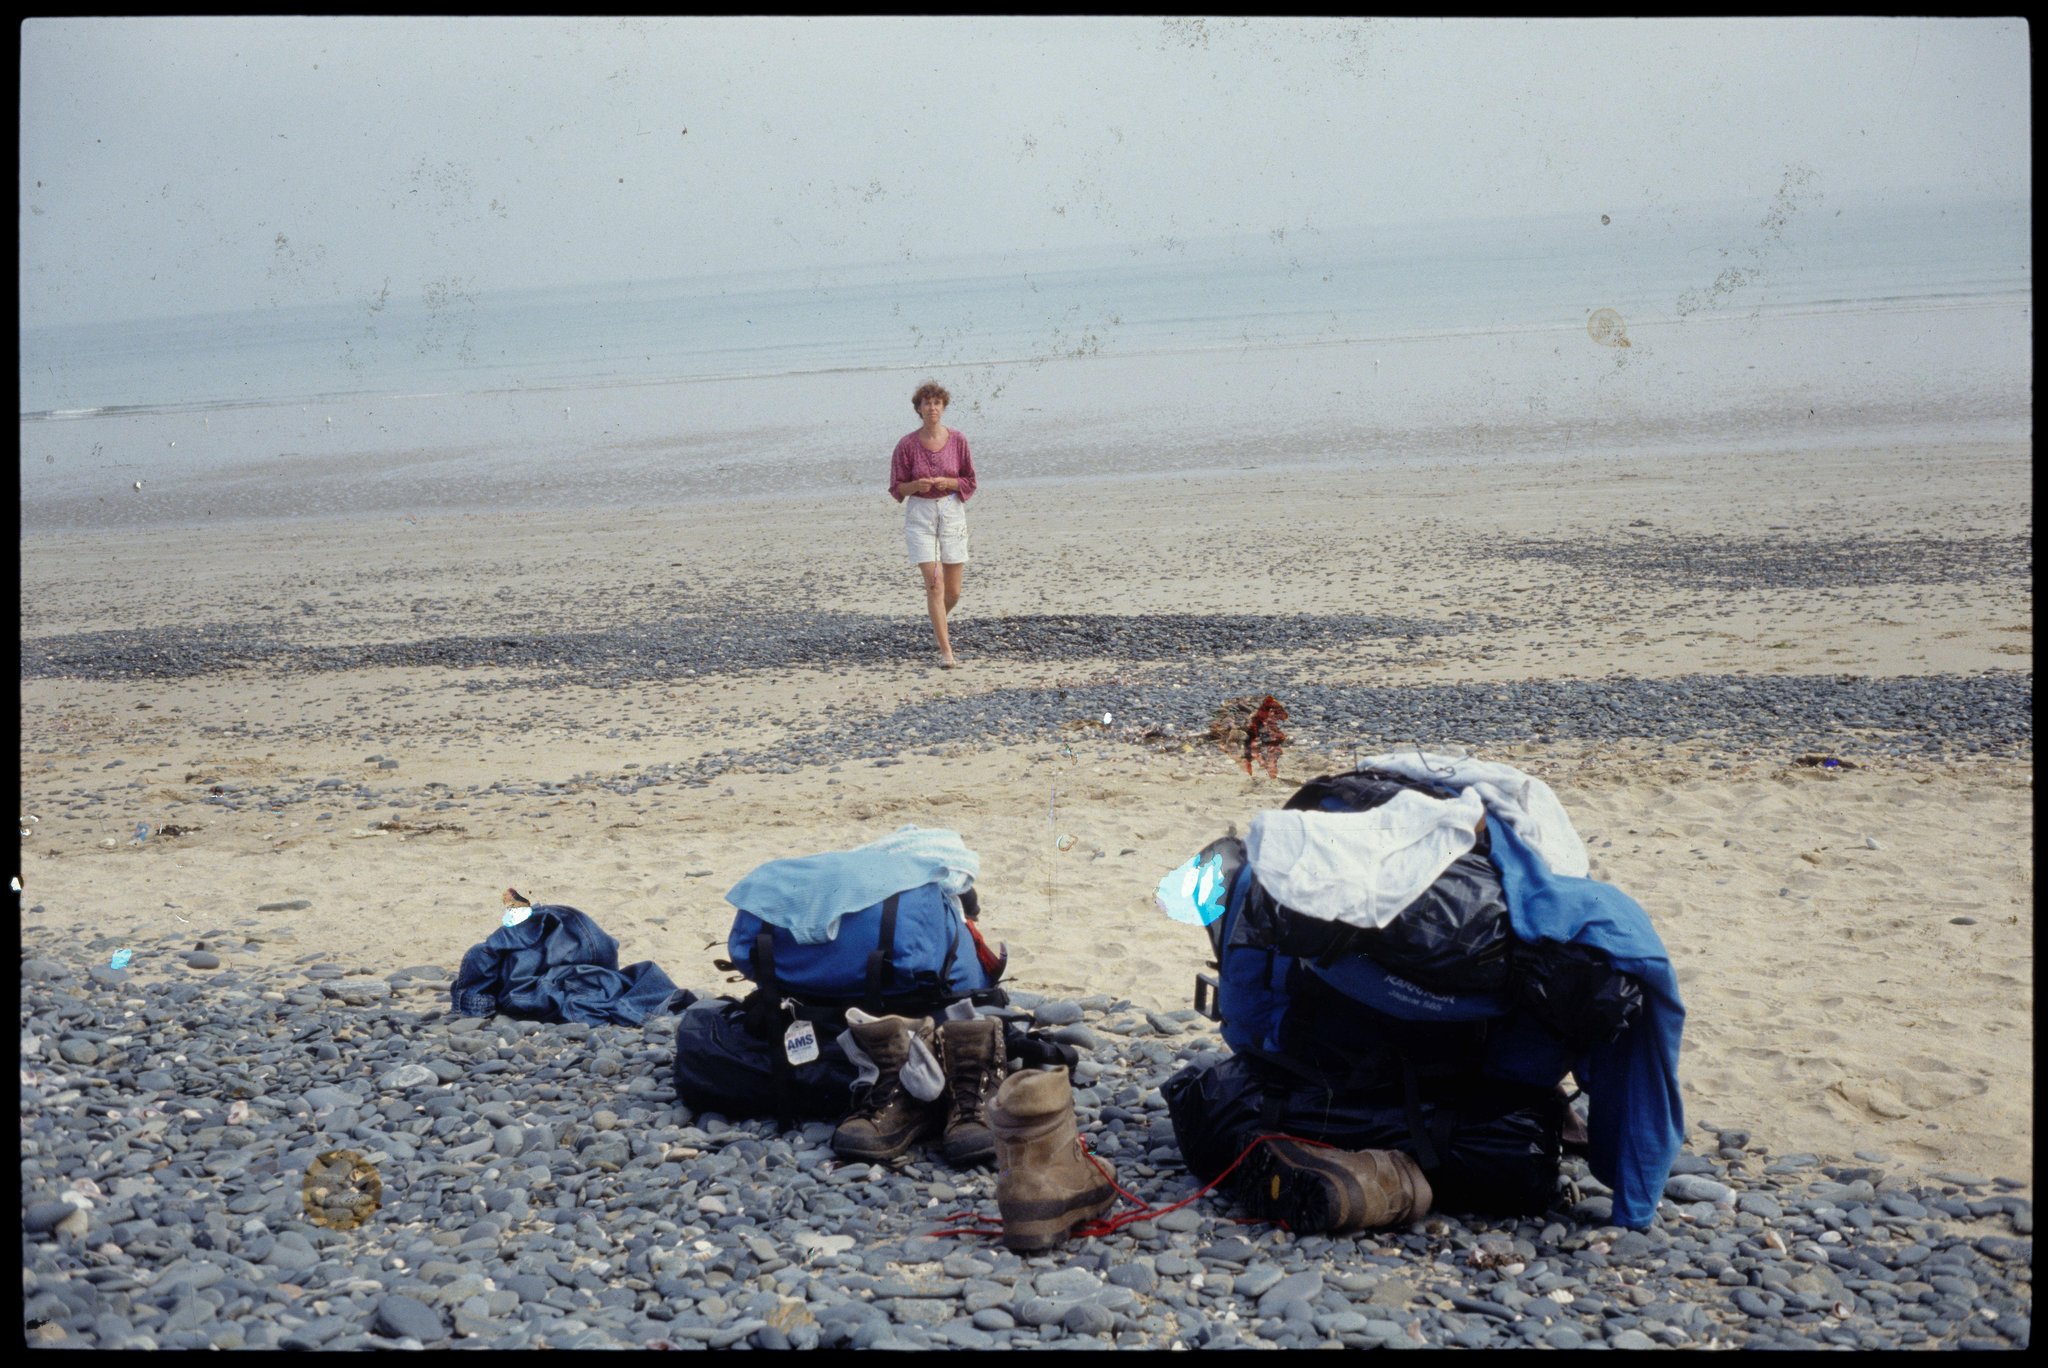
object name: slide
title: Diapositief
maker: Anonymous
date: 1907-1935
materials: film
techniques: slide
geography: netherlands